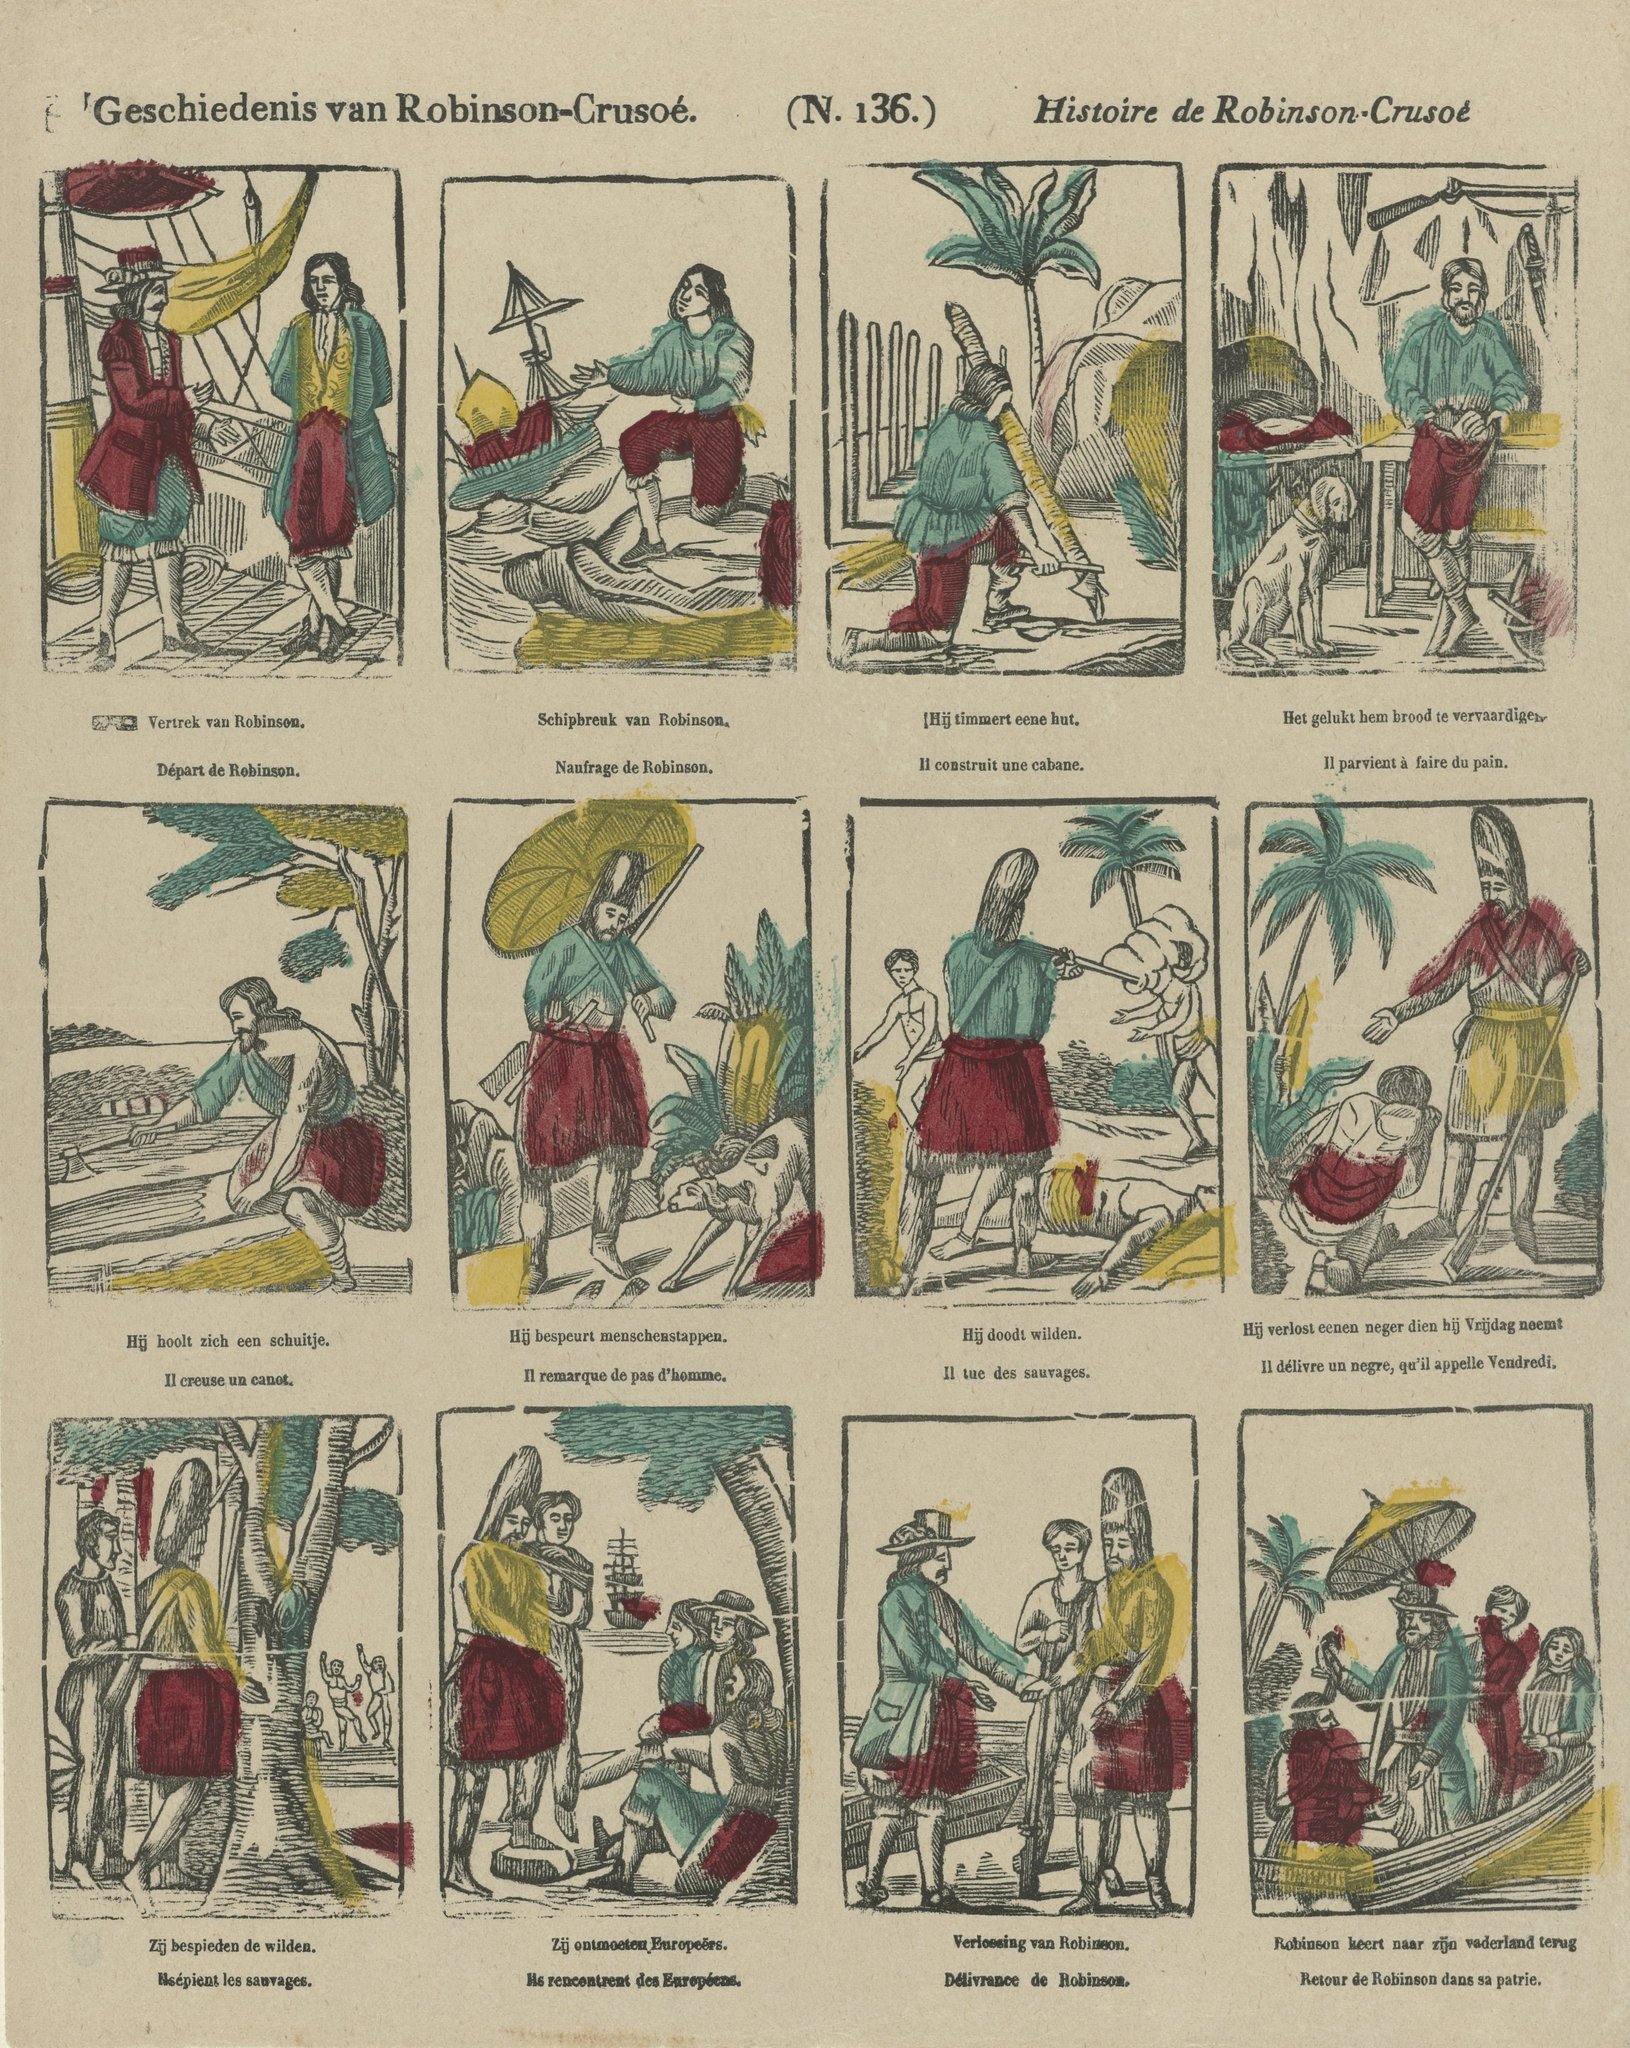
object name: print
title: Geschiedenis van Robinson-Crusoé / Histoire de Robinson-Crusoé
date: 1800-1833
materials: paper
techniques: colour, letterpress printing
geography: turnhout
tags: (scenes from) specific works of literature: defoe, robinson crusoe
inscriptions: collector's mark: Lugt 2760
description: Blad met 16 voorstellingen uit het verhaal van Robinson Crusoe die strandt op een eiland. Onder elke afbeelding een onderschrift in het Nederlands en in het Frans. Genummerd midden boven: (N. 136.).